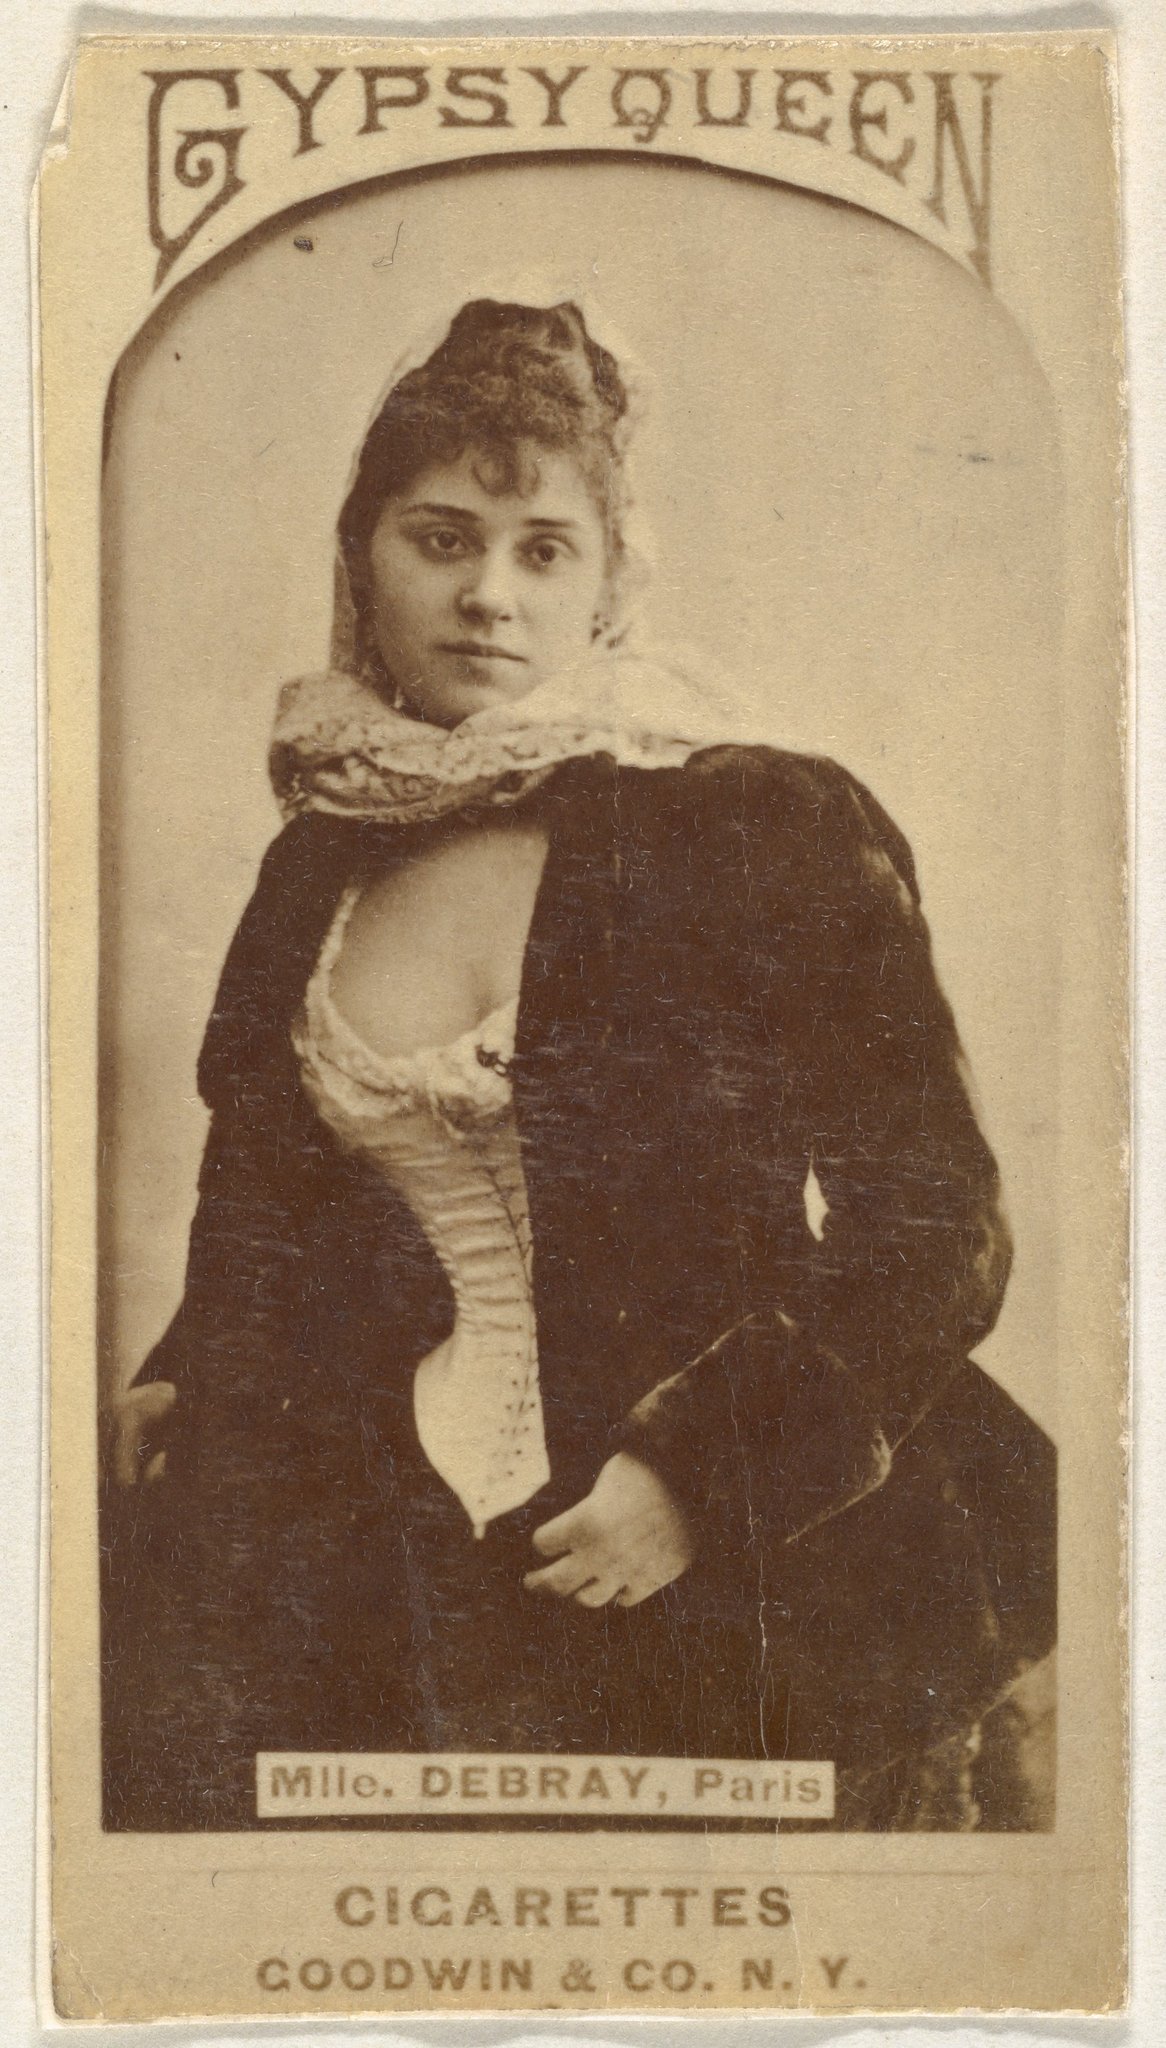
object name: photograph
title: Mlle. Debray, Paris, from the Actors and Actresses series (N171) for Gypsy Queen Cigarettes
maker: goodwin & company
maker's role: publisher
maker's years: 1850-1950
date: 1886-1890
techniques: albumen silver print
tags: portraits,women,actresses